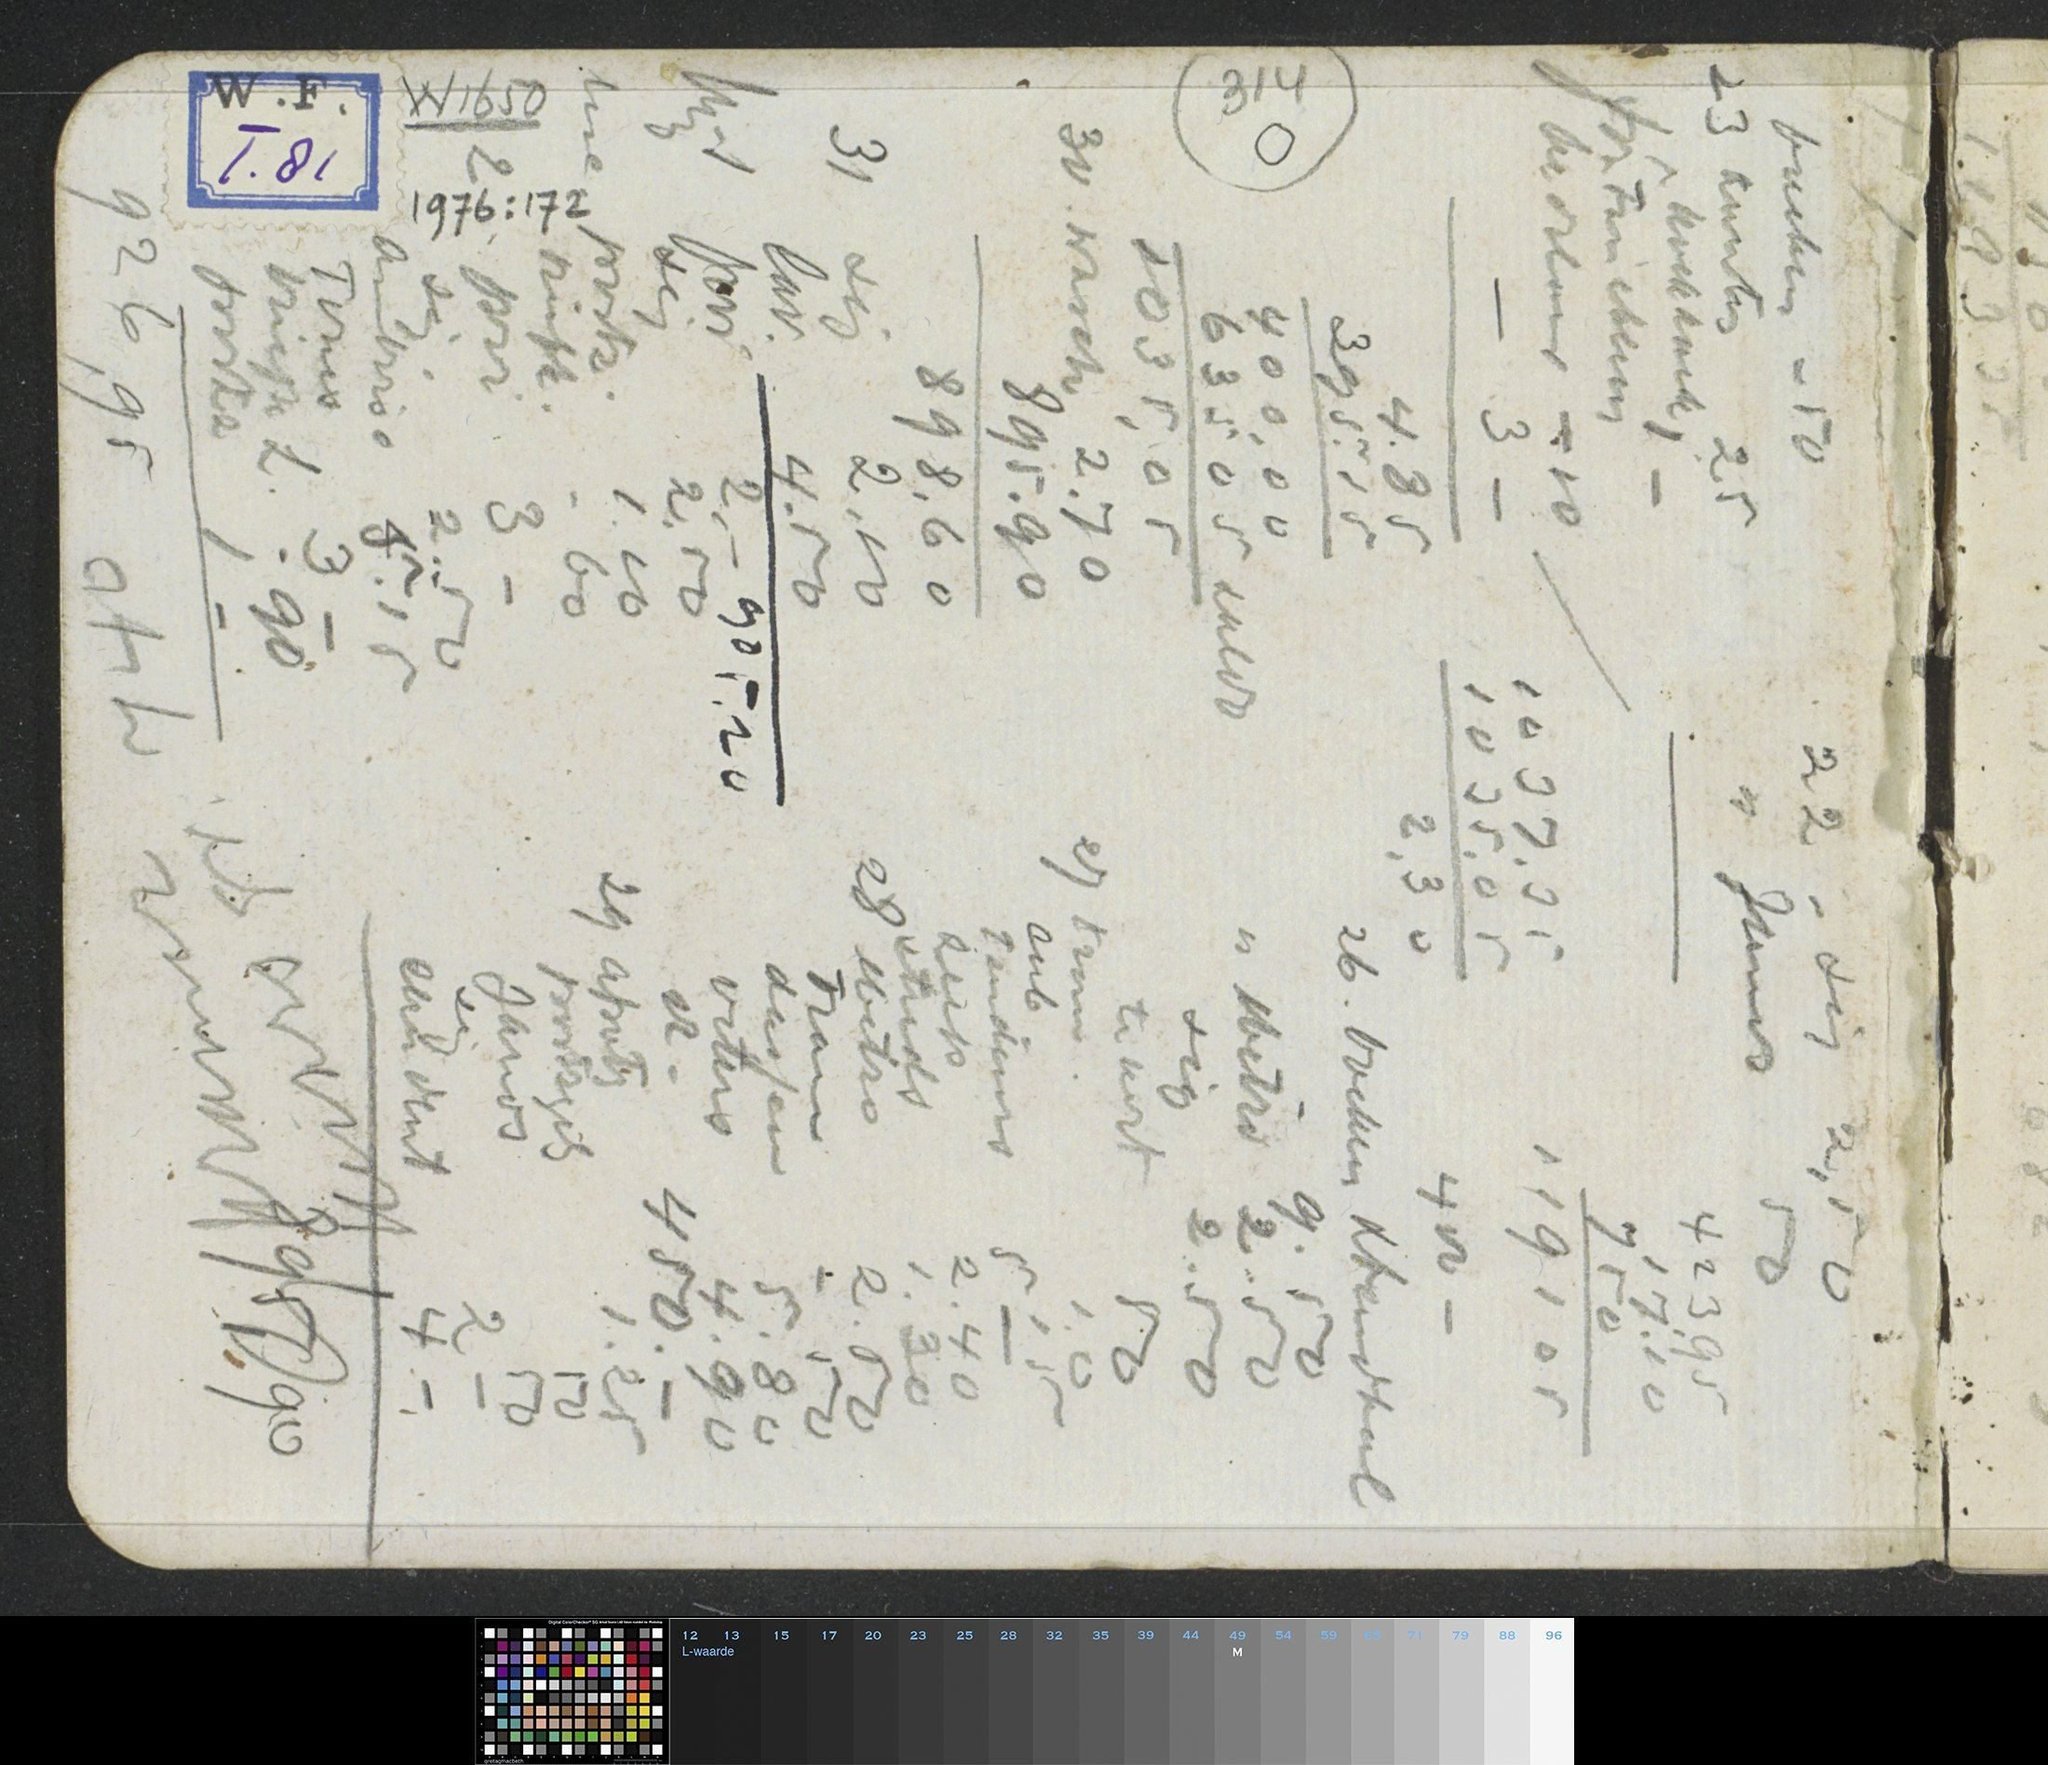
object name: endleaf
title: Annotaties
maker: willem witsen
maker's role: draughtsman, painter, print maker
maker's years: 1860-1923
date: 1915-1921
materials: ink, paper, pencil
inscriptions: annotation: ‘[...]’, annotation: ‘W.F./ T. 81’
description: Schutblad A, voorste schutblad, uit een schetsboek met 23 bladen.